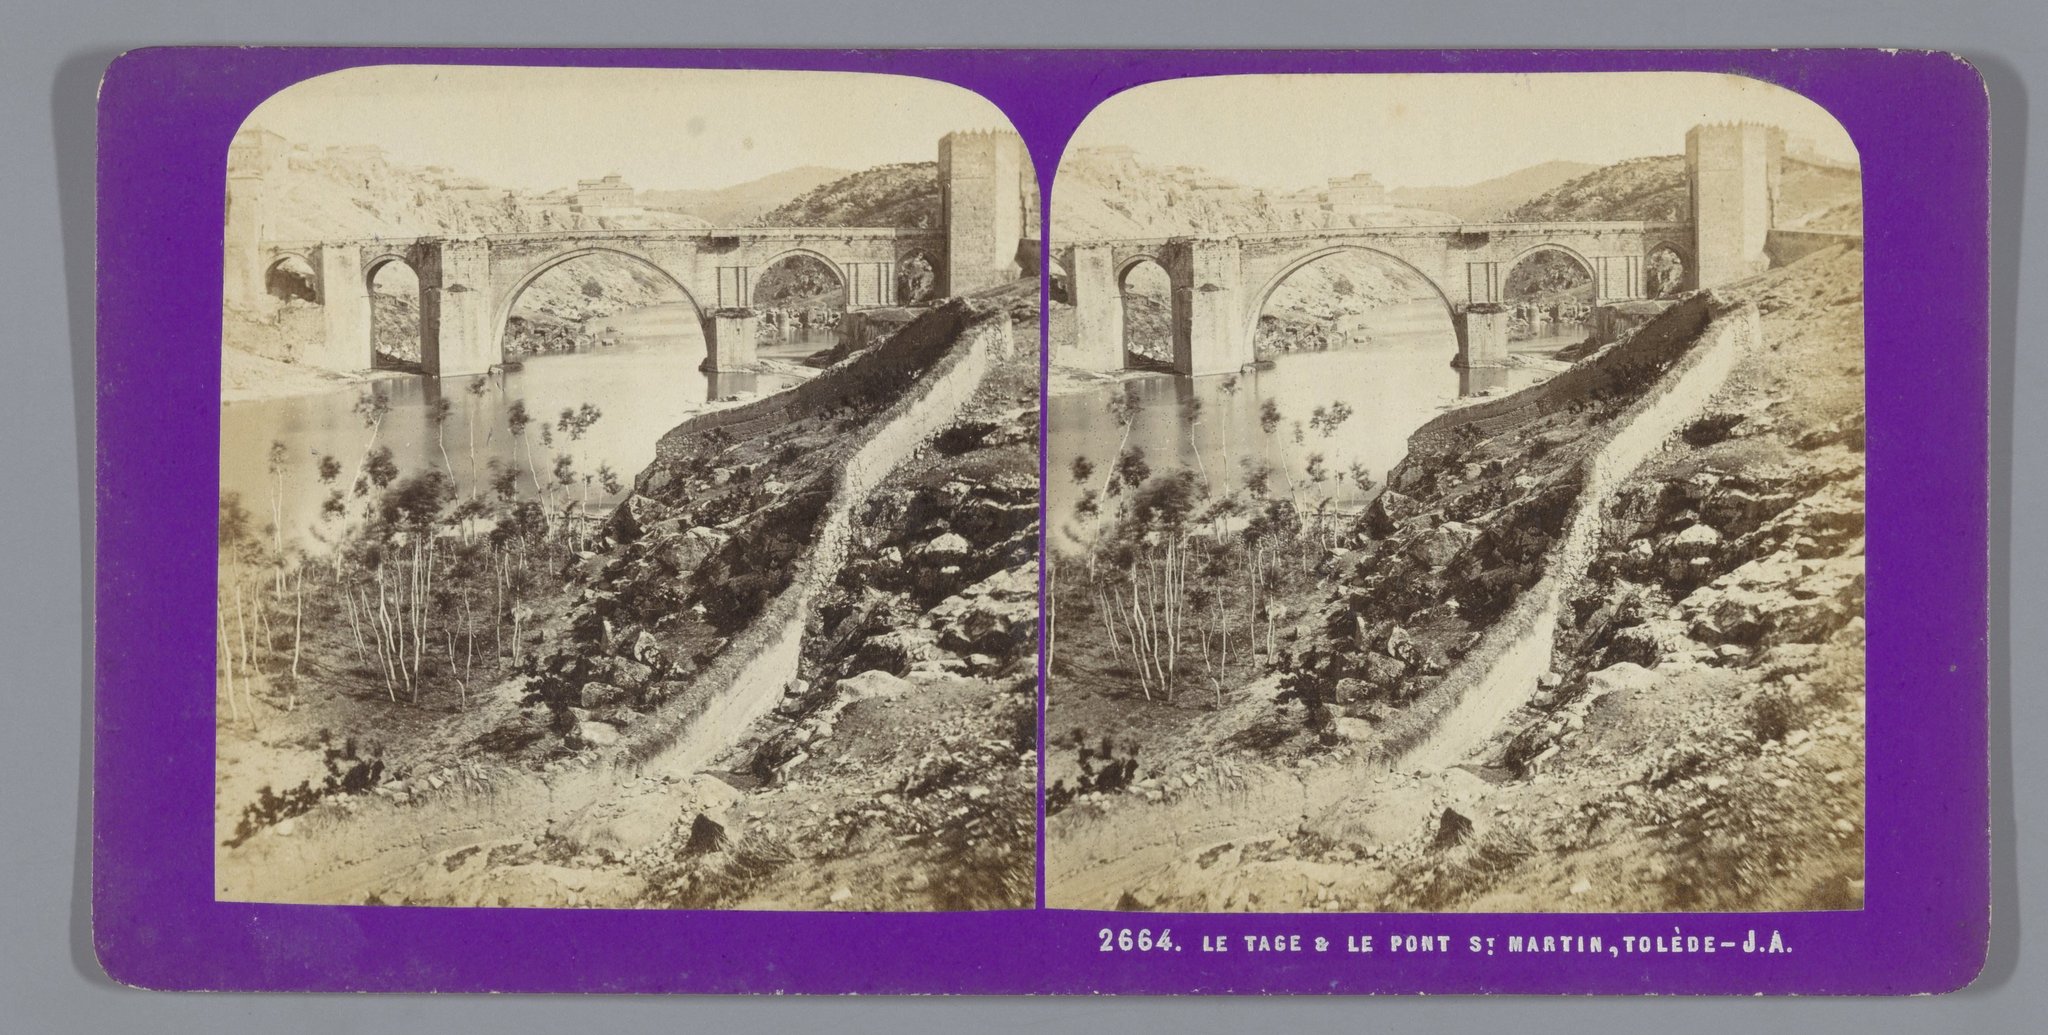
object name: stereograph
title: Gezicht op de Puente de San Martín te Toledo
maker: jean andrieu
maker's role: fotograaf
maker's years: 1816-1872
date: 1862-1876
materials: cardboard, photographic support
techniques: albumen print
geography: toledo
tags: landscape with bridge, viaduct or aqueduct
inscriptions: number: ‘2664.’